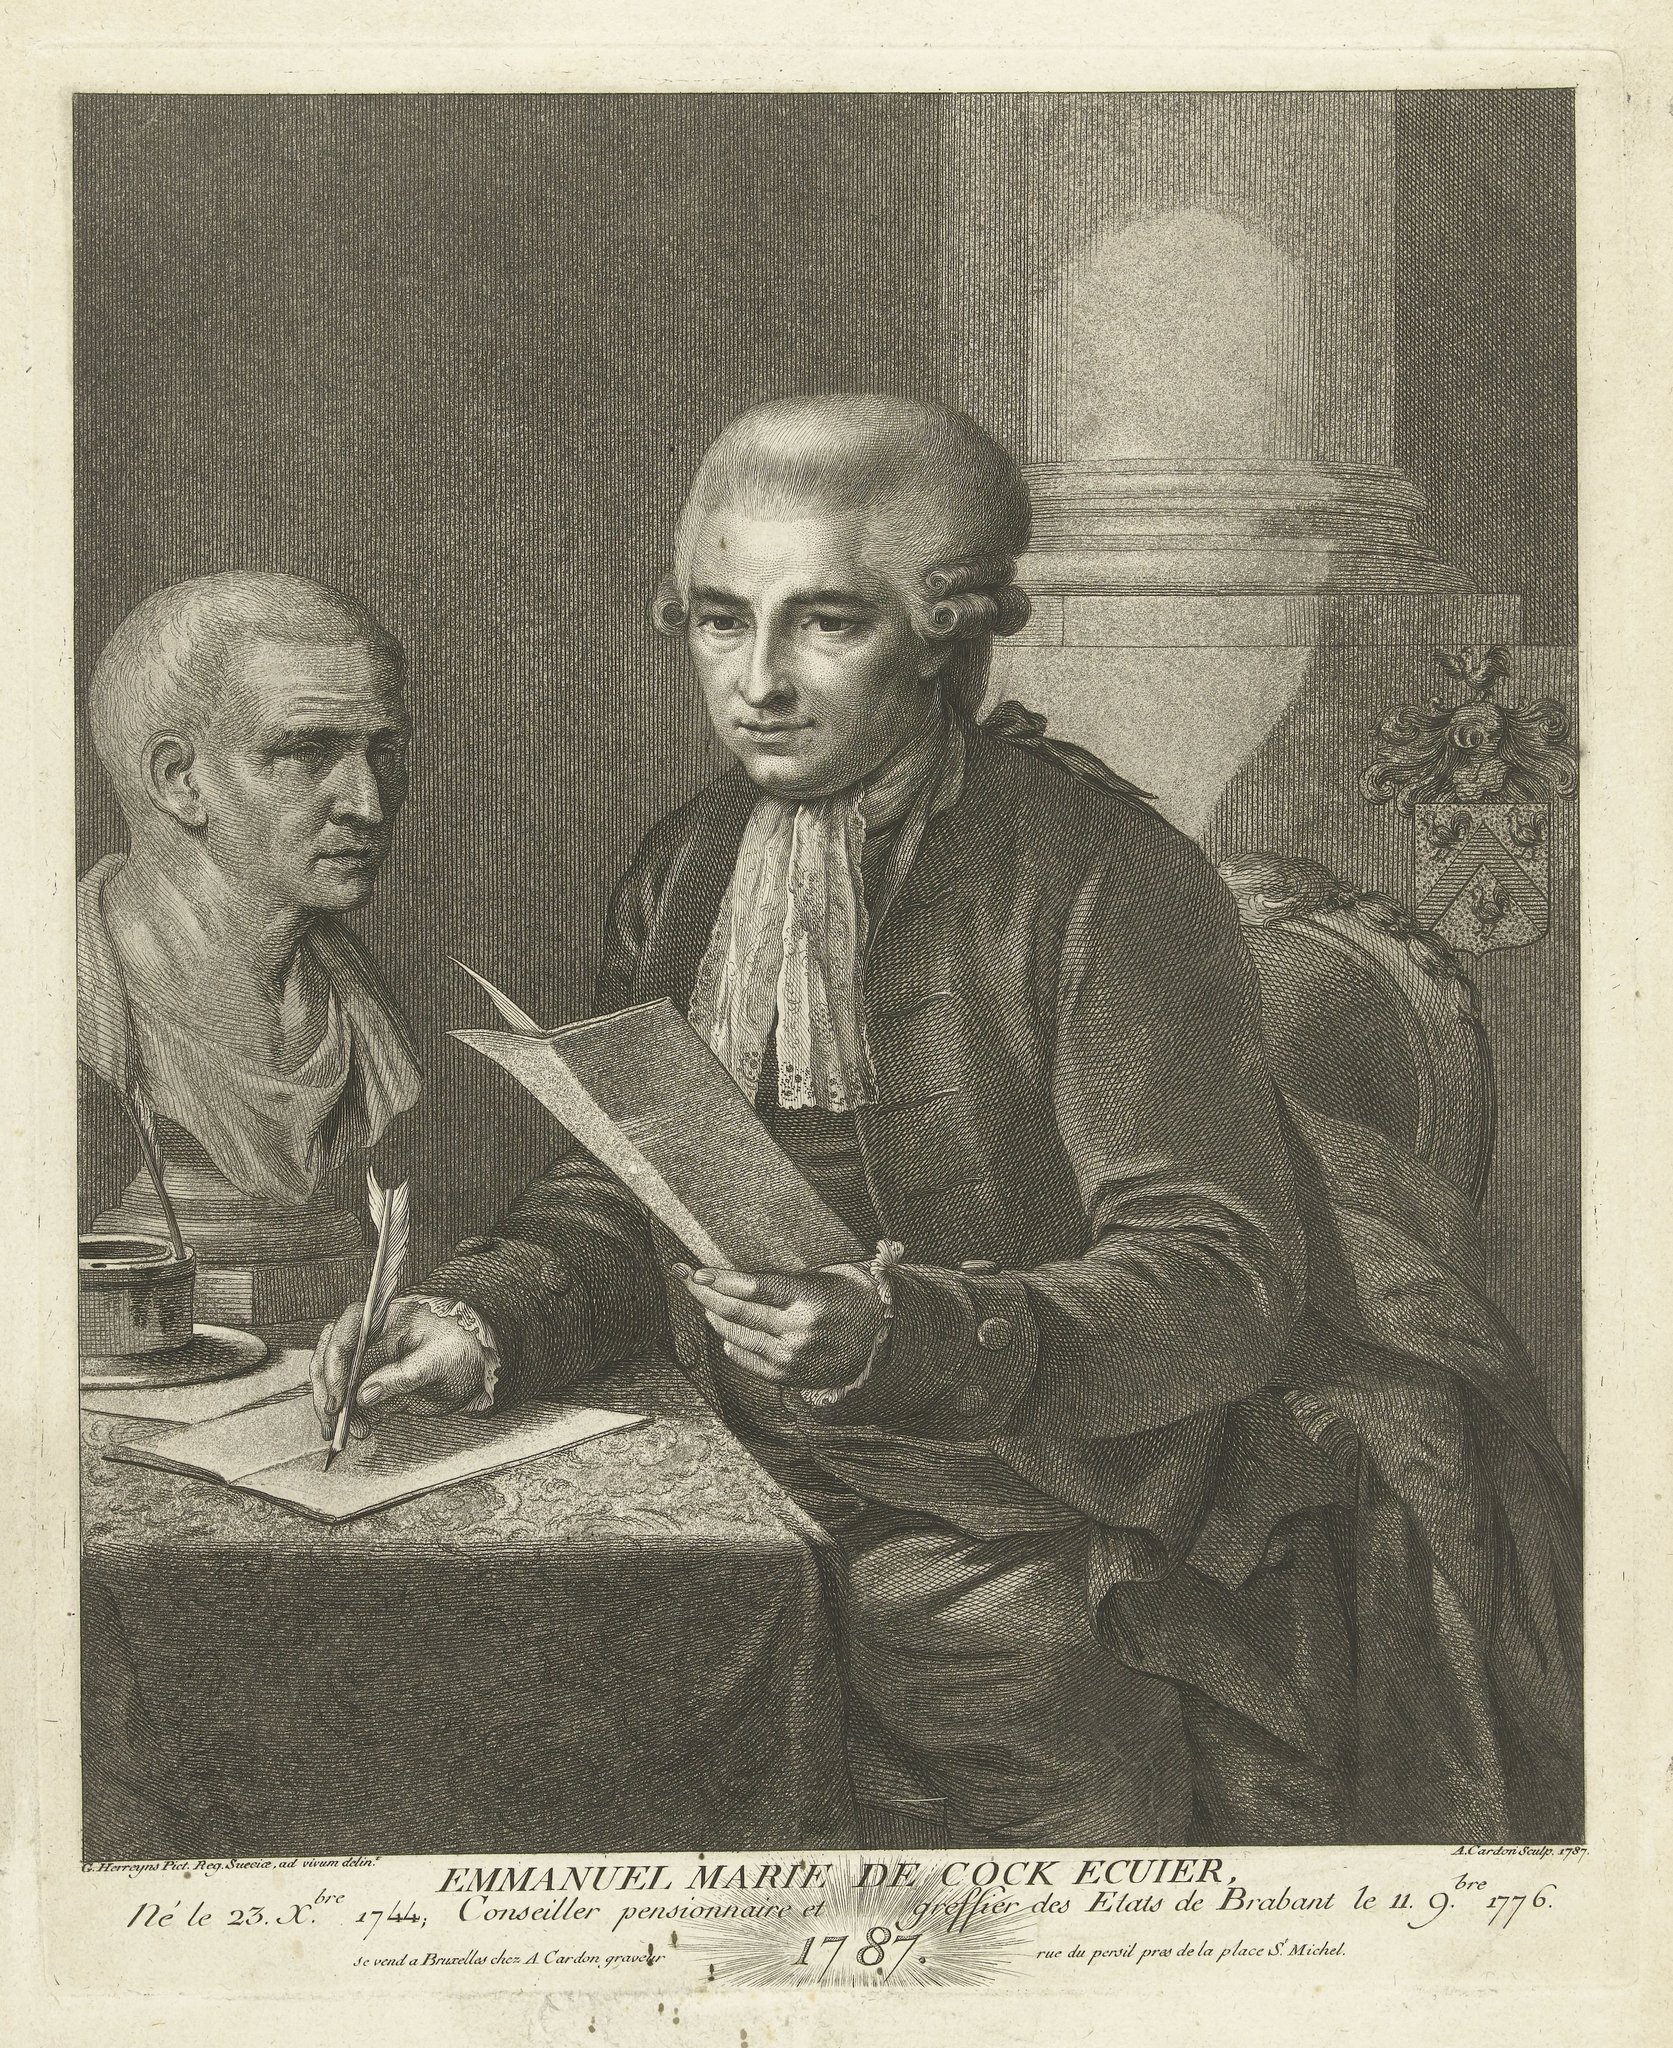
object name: print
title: Portret van Emannuel Marie de Cock, pensionaris van de Staten van Brabant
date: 1787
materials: paper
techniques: aquatint, engraving, etching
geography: brussels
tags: pensionaris, emmanuel marie de cock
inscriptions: collector's mark: Lugt 2228